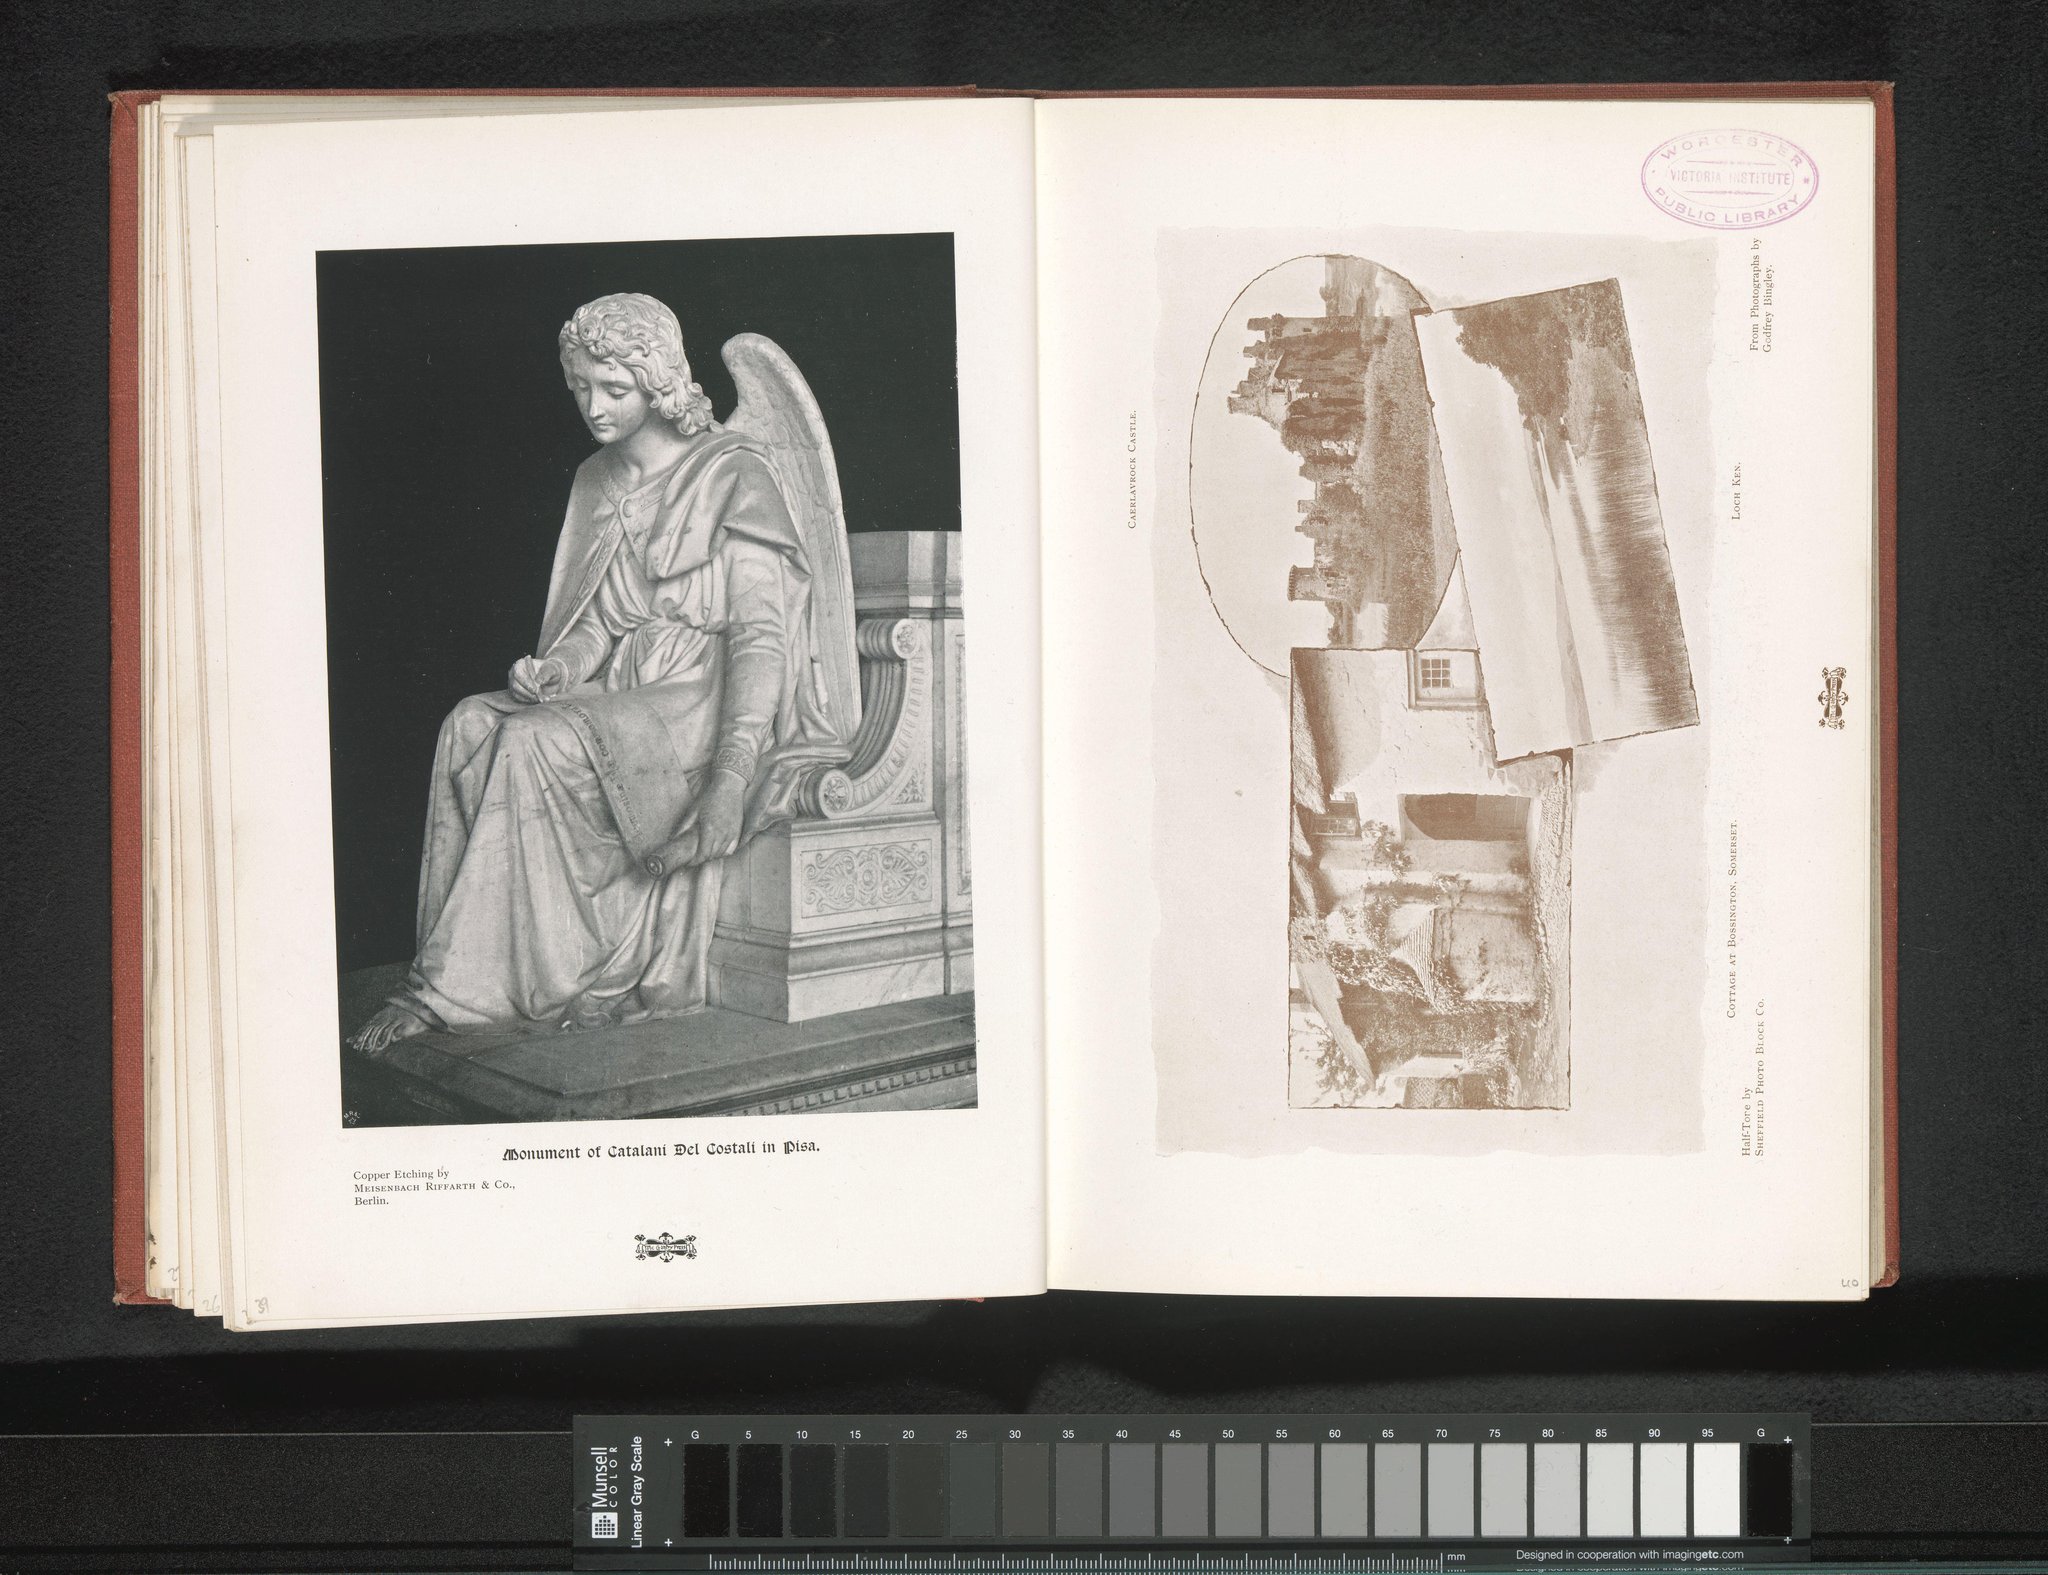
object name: photomechanical print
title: Standbeeld van een gezeten engel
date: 1895-1900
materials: paper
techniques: autotype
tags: angel(s) with book(-scroll) or banderole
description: Prent op vierde ongenummerde pagina na pagina 32.